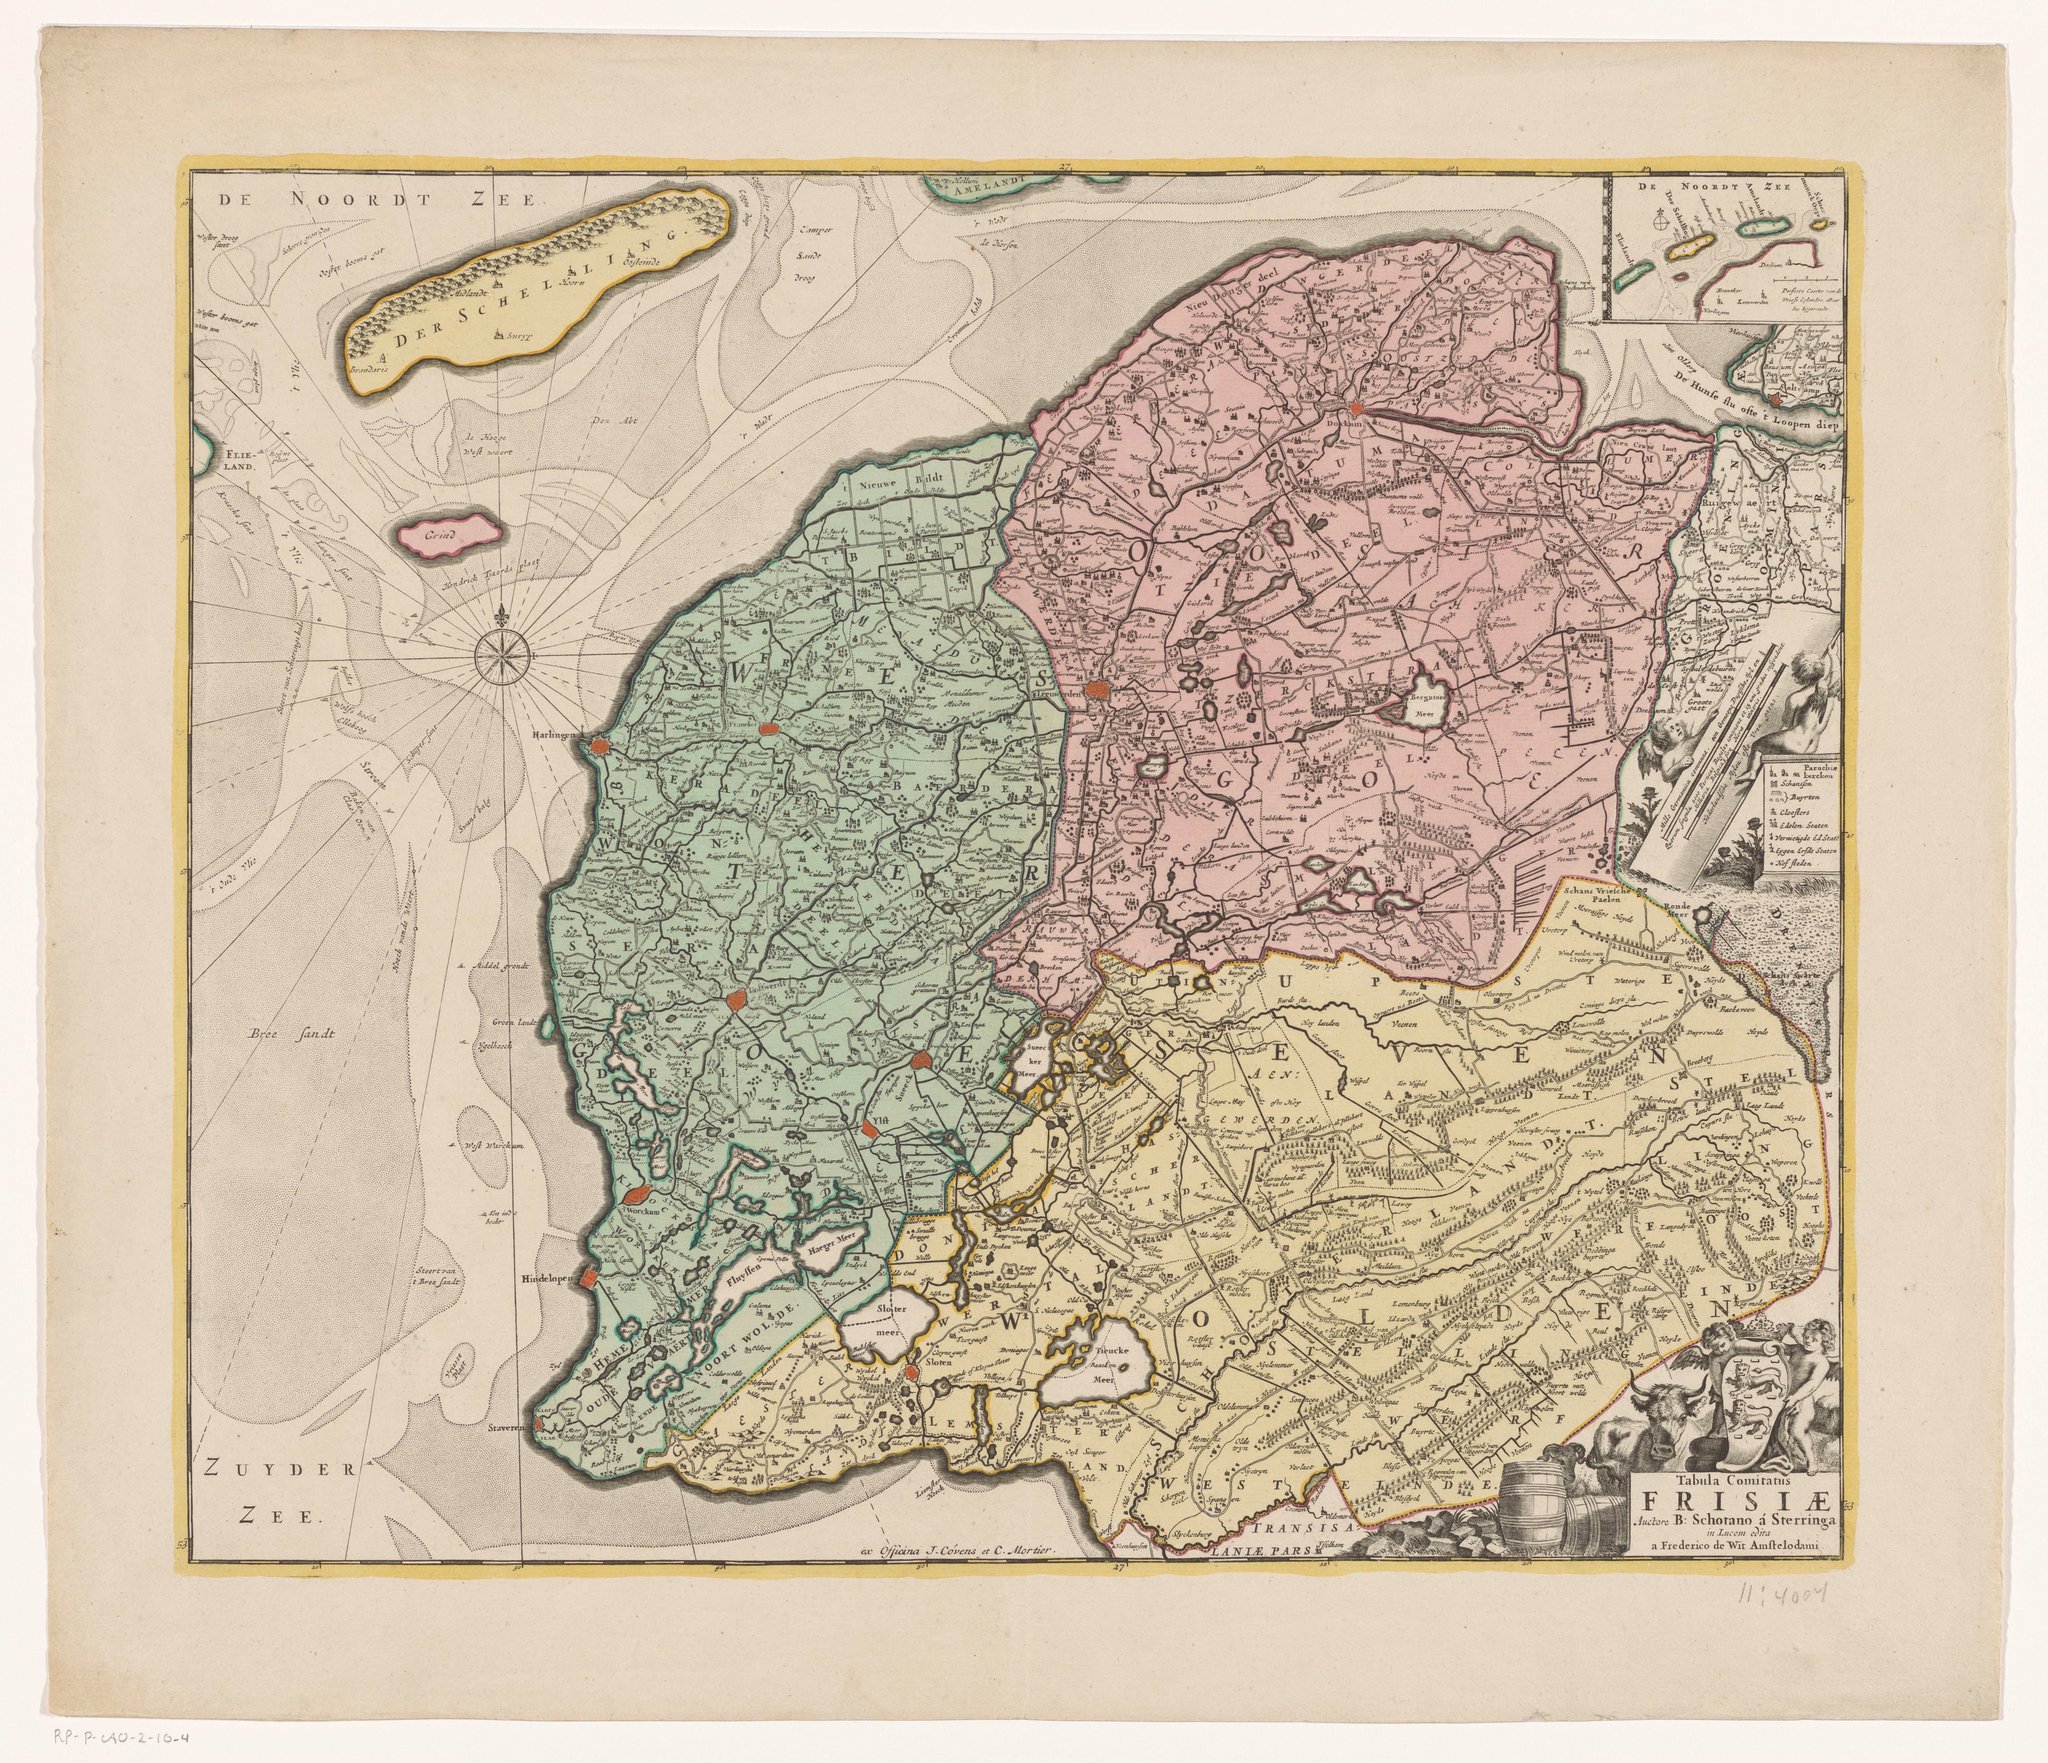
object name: print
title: Tabula comitatus Frisiae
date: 1721-1774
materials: paper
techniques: engraving, hand coloring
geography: amsterdam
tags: coat of arms (as symbol of the state, etc.), maps of separate countries or regions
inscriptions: collector's mark: Lugt 2228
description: Rechtsboven inzetkaart met Vlieland, Terschelling, Ameland en Schiermonnikoog. Rechts in het midden twee putti met legenda en twee schaalstokken: Mille Germanica commune / een gemeene Duytsche myl en 0.5, Nederlandsche mylen ofte uren gaens. Rechtsonder titelcartouche met daarboven het wapen van Friesland. Gradenverdeling langs de randen.